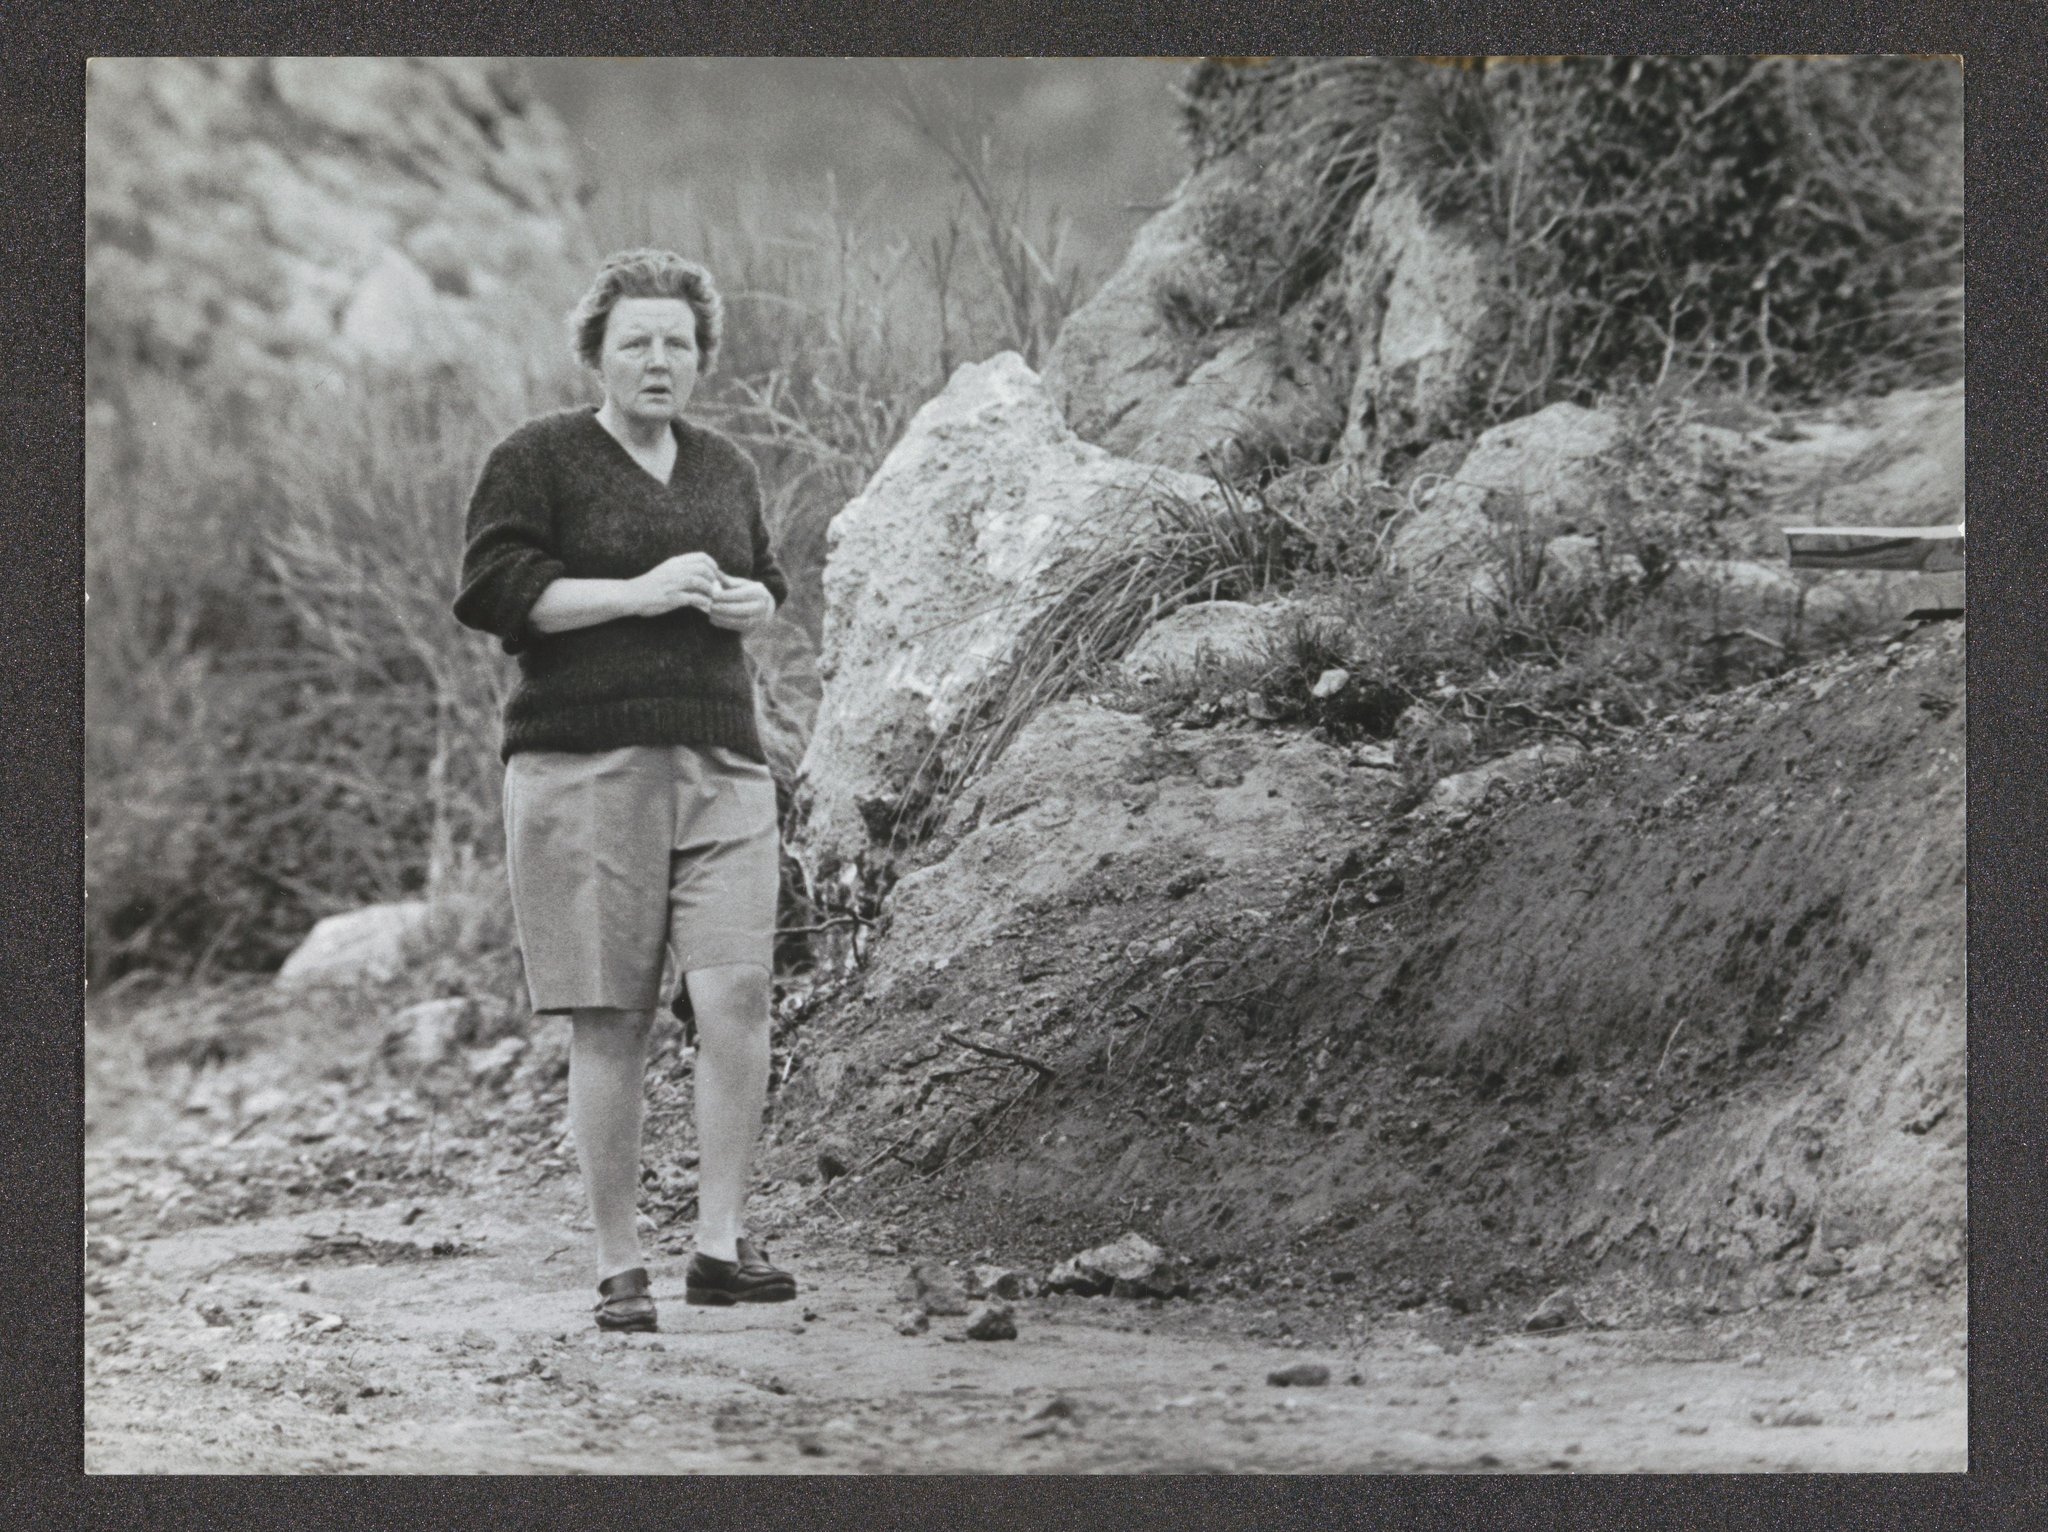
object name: photograph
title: Roma fateitalia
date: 1962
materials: paper, photographic support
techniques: gelatin silver print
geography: rome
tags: the hague, juliana of the netherlands, italy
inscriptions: annotation: ‘I reali d'olanda... di passaggio’, stamp: ‘Copyright ANEFO Kerkstraat 310 Ams’